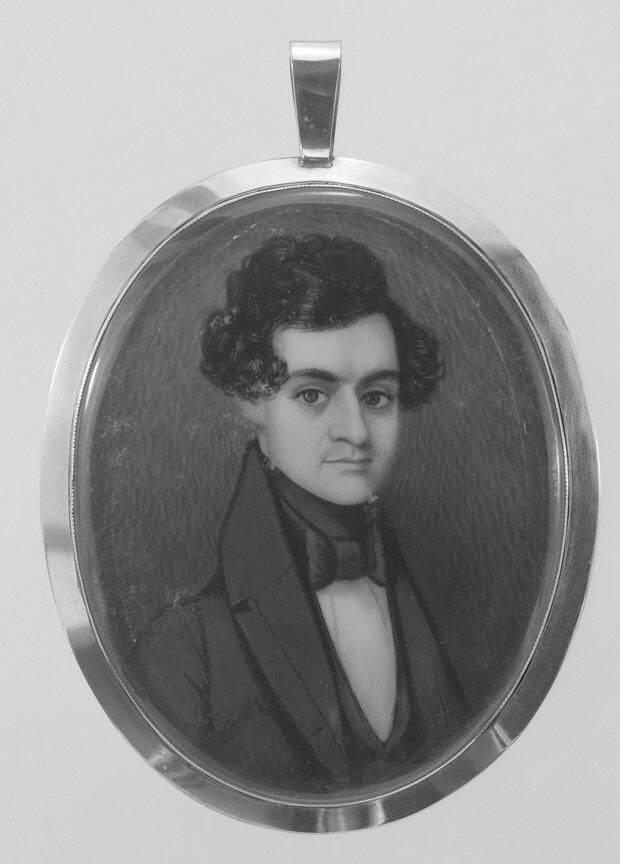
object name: painting, miniature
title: Portrait of a Gentleman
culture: american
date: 1830-1835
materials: ivory, watercolor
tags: men,portraits